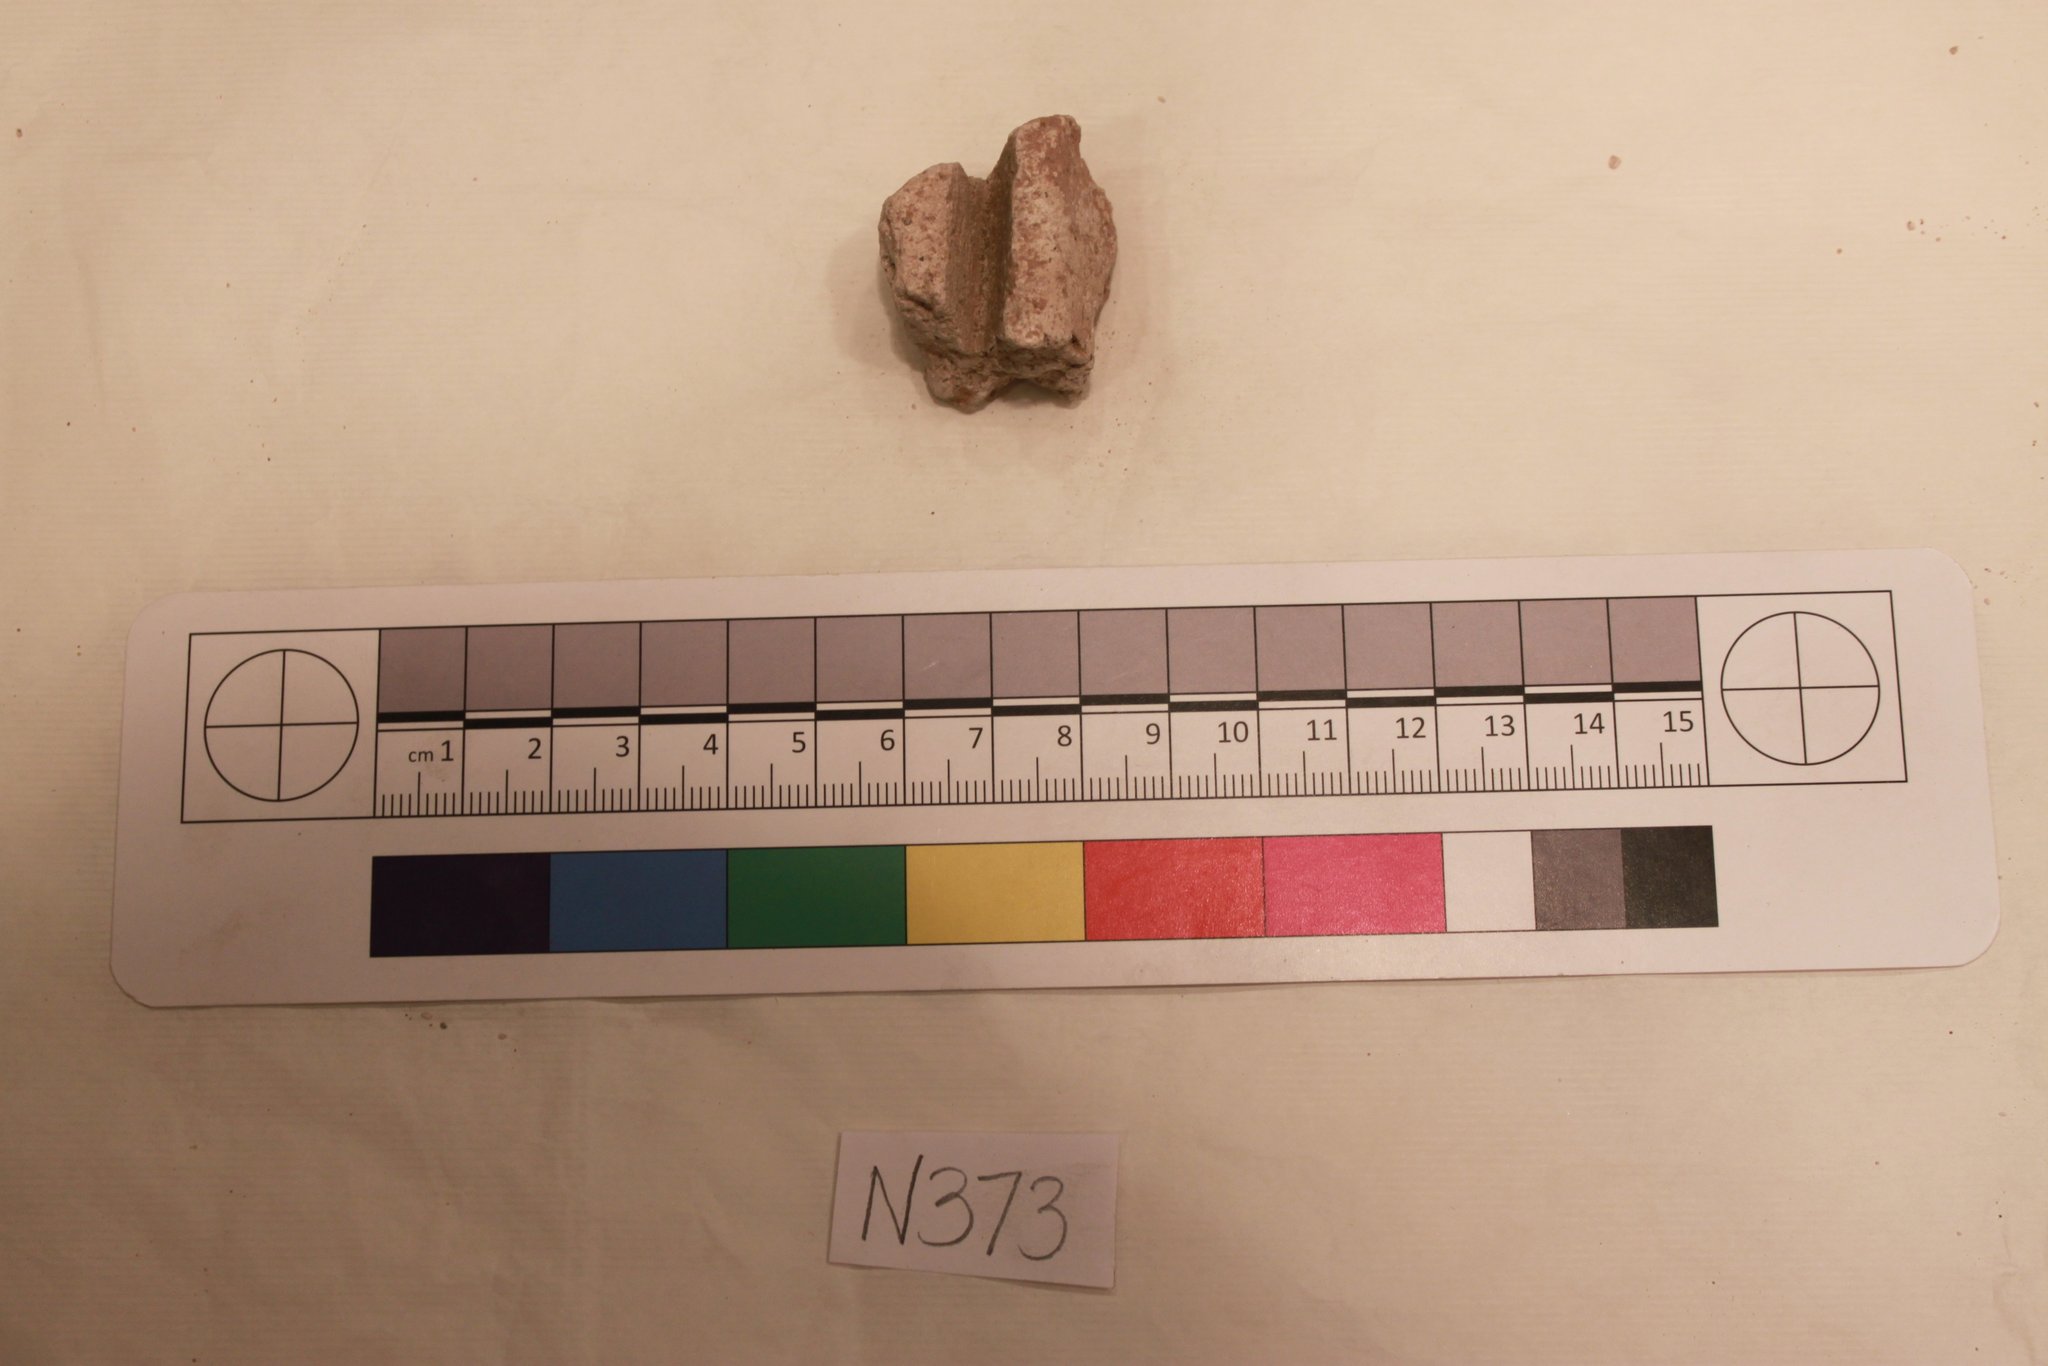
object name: fragment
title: Stucco Fragment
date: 701-1200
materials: plaster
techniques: carving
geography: iran